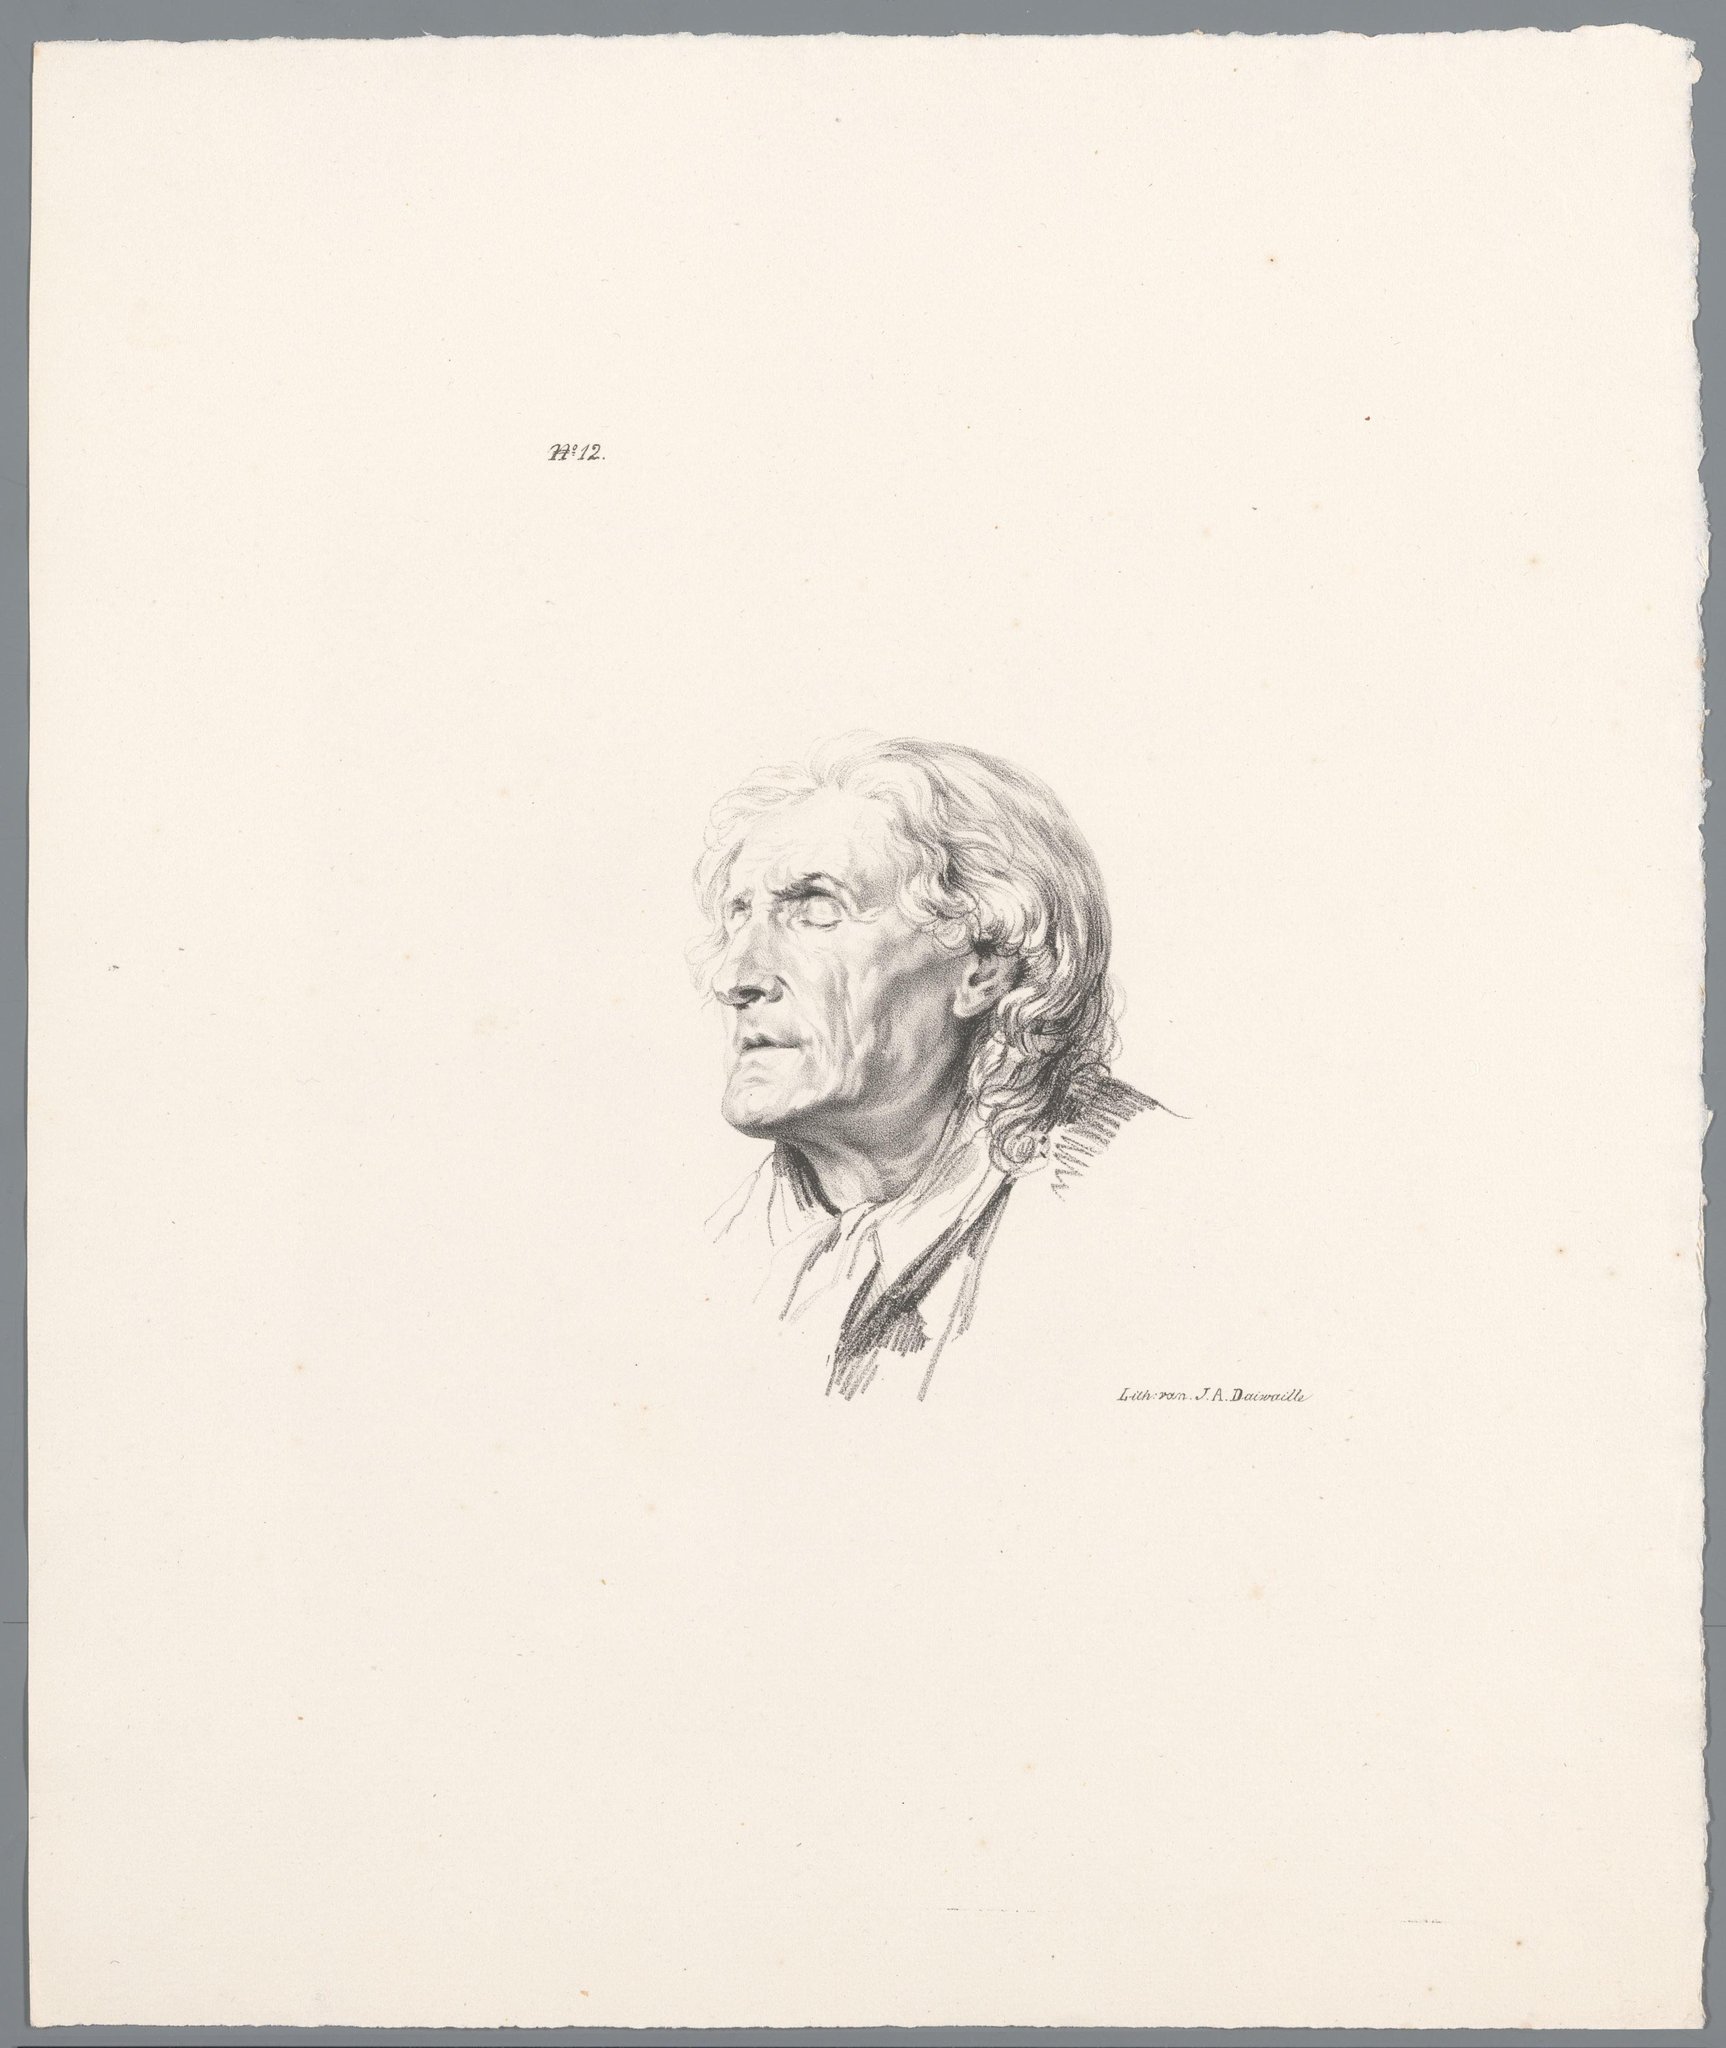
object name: print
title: Oude man met gesloten ogen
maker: jean augustin daiwaille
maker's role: draughtsman, print maker, printer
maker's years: 1786-1850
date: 1820-1830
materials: paper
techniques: lithograph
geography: amsterdam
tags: old man, eyes closed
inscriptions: collector's mark: Lugt 2228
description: 'Hartstochten na J.B. Greuze' bestaat uit twee of drie genummerde reeksen. (Sommige nummers komen drie keer voor op drie verschillende afbeeldingen.) Binnen deze omslag bevinden zich achttien verschillende afbeeldingen. Mogelijk heeft dit te maken met de twee momenten waarop Daiwaille de reeks uitgaf, ten tijden van zijn directeurschap aan de Rijksakademie in Amsterdam en daarna als zelfstandige. De omslag behoort waarschijnlijk bij een van deze twee series. Zie Marres-Schretlen in het Bulletin van het Rijksmuseum.